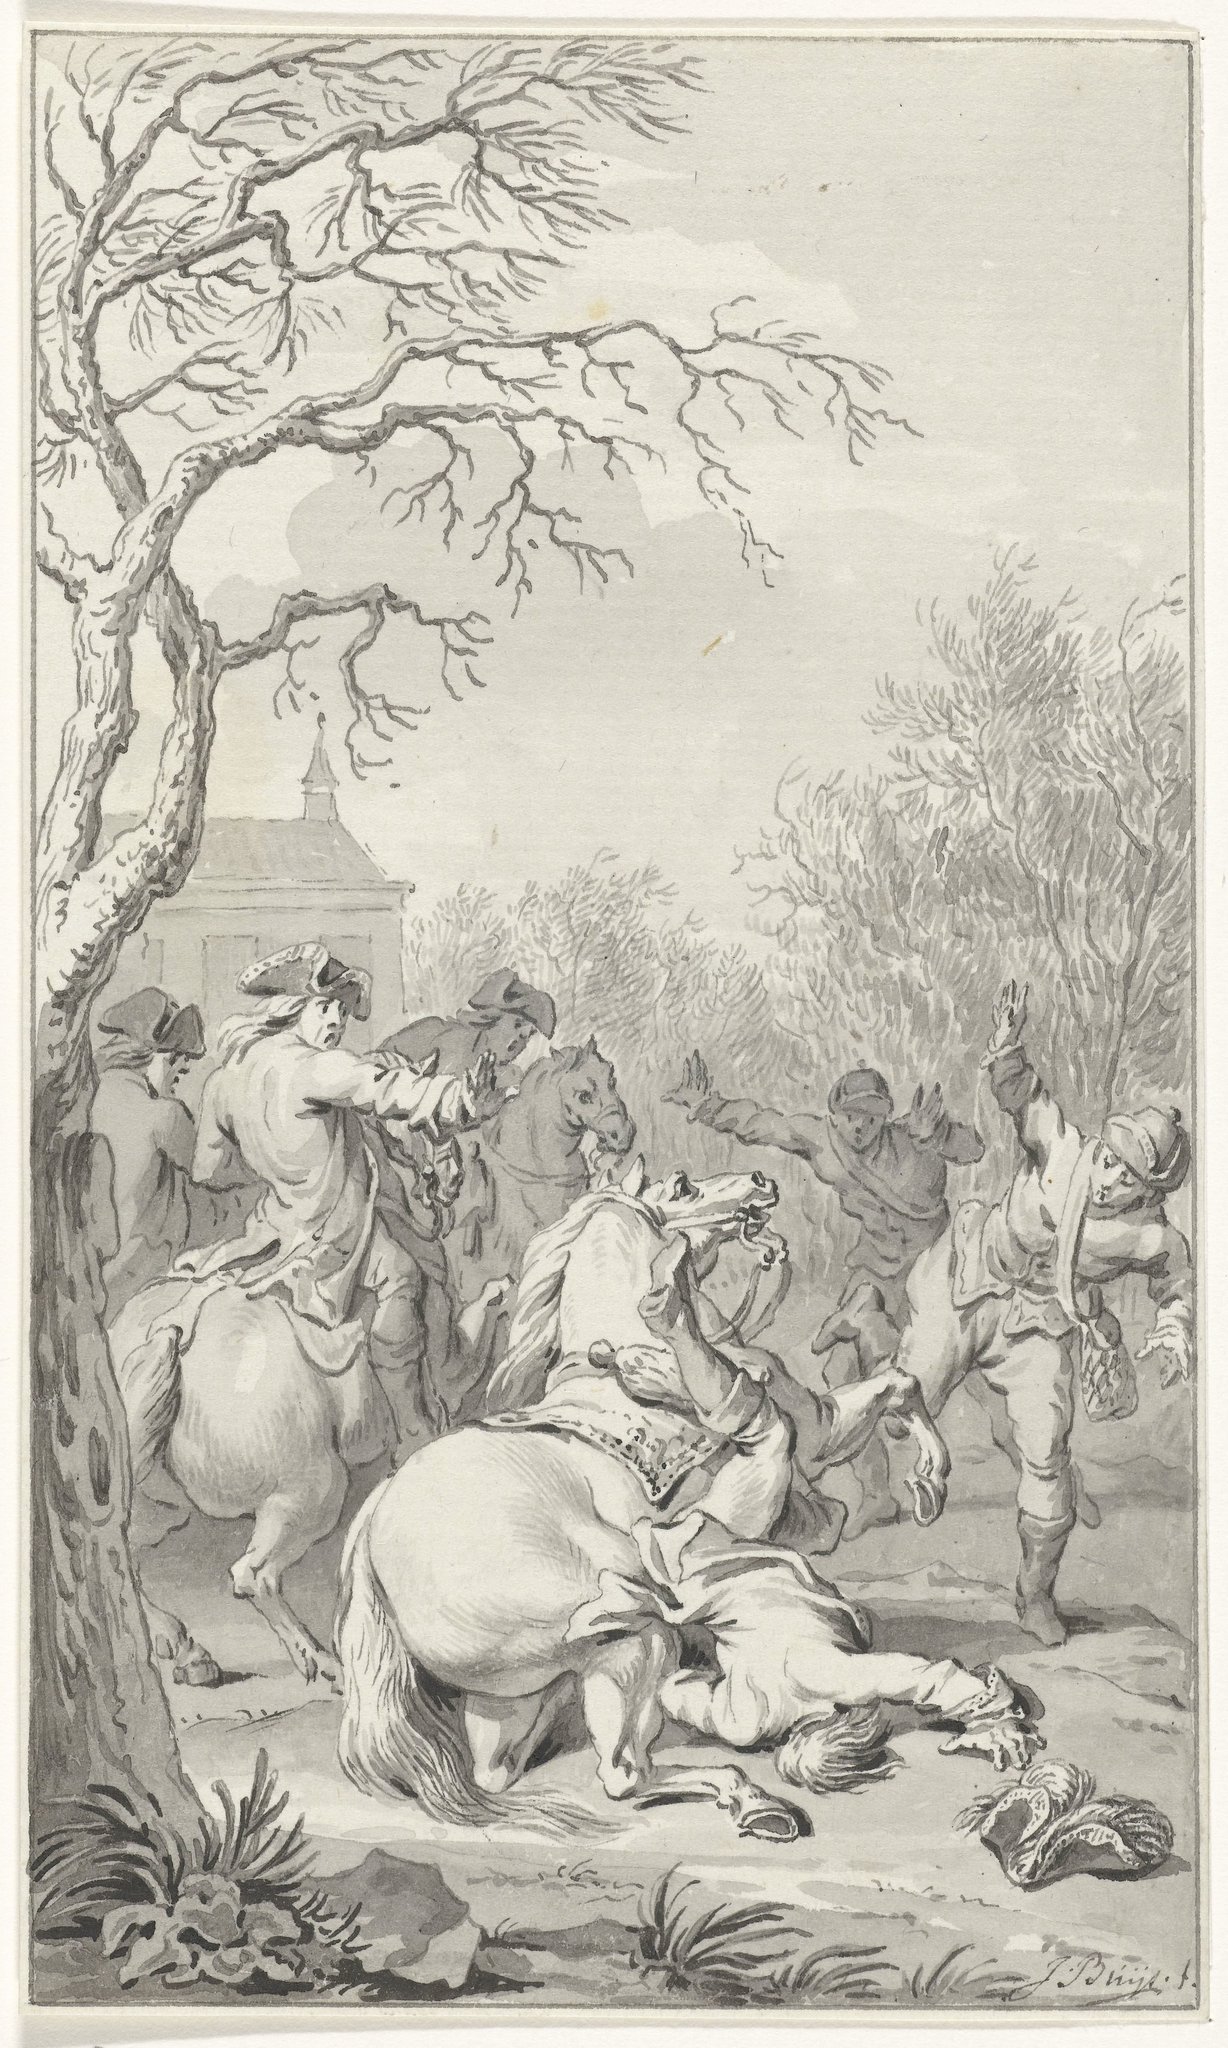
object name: drawing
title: Dodelijke val van Willem III van zijn paard, 4 maart 1702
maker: jacobus buys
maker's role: draughtsman, print maker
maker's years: 1724-1801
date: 1792-1794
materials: ink, paper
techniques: brush, pen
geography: northern netherlands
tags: the hague, william iii (prince of orange and king of england, scotland, and ireland), death by accident (non-violent death), hunting accidents, dying from the effects of a fall, england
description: Op 4 maart 1702, tijdens een jachtpartij in de buurt van Londen, kwam de koning-stadhouder ten val doordat zijn paard struikelde. Twee weken later overleed de prins in een Londens paleis. Ontwerptekening voor illustratie in: Jacobus Kok, Vaderlandsch Woordenboek, Johannes Allart, Amsterdam 1785-1799, 35 delen, dl. XXXII, pl. I.